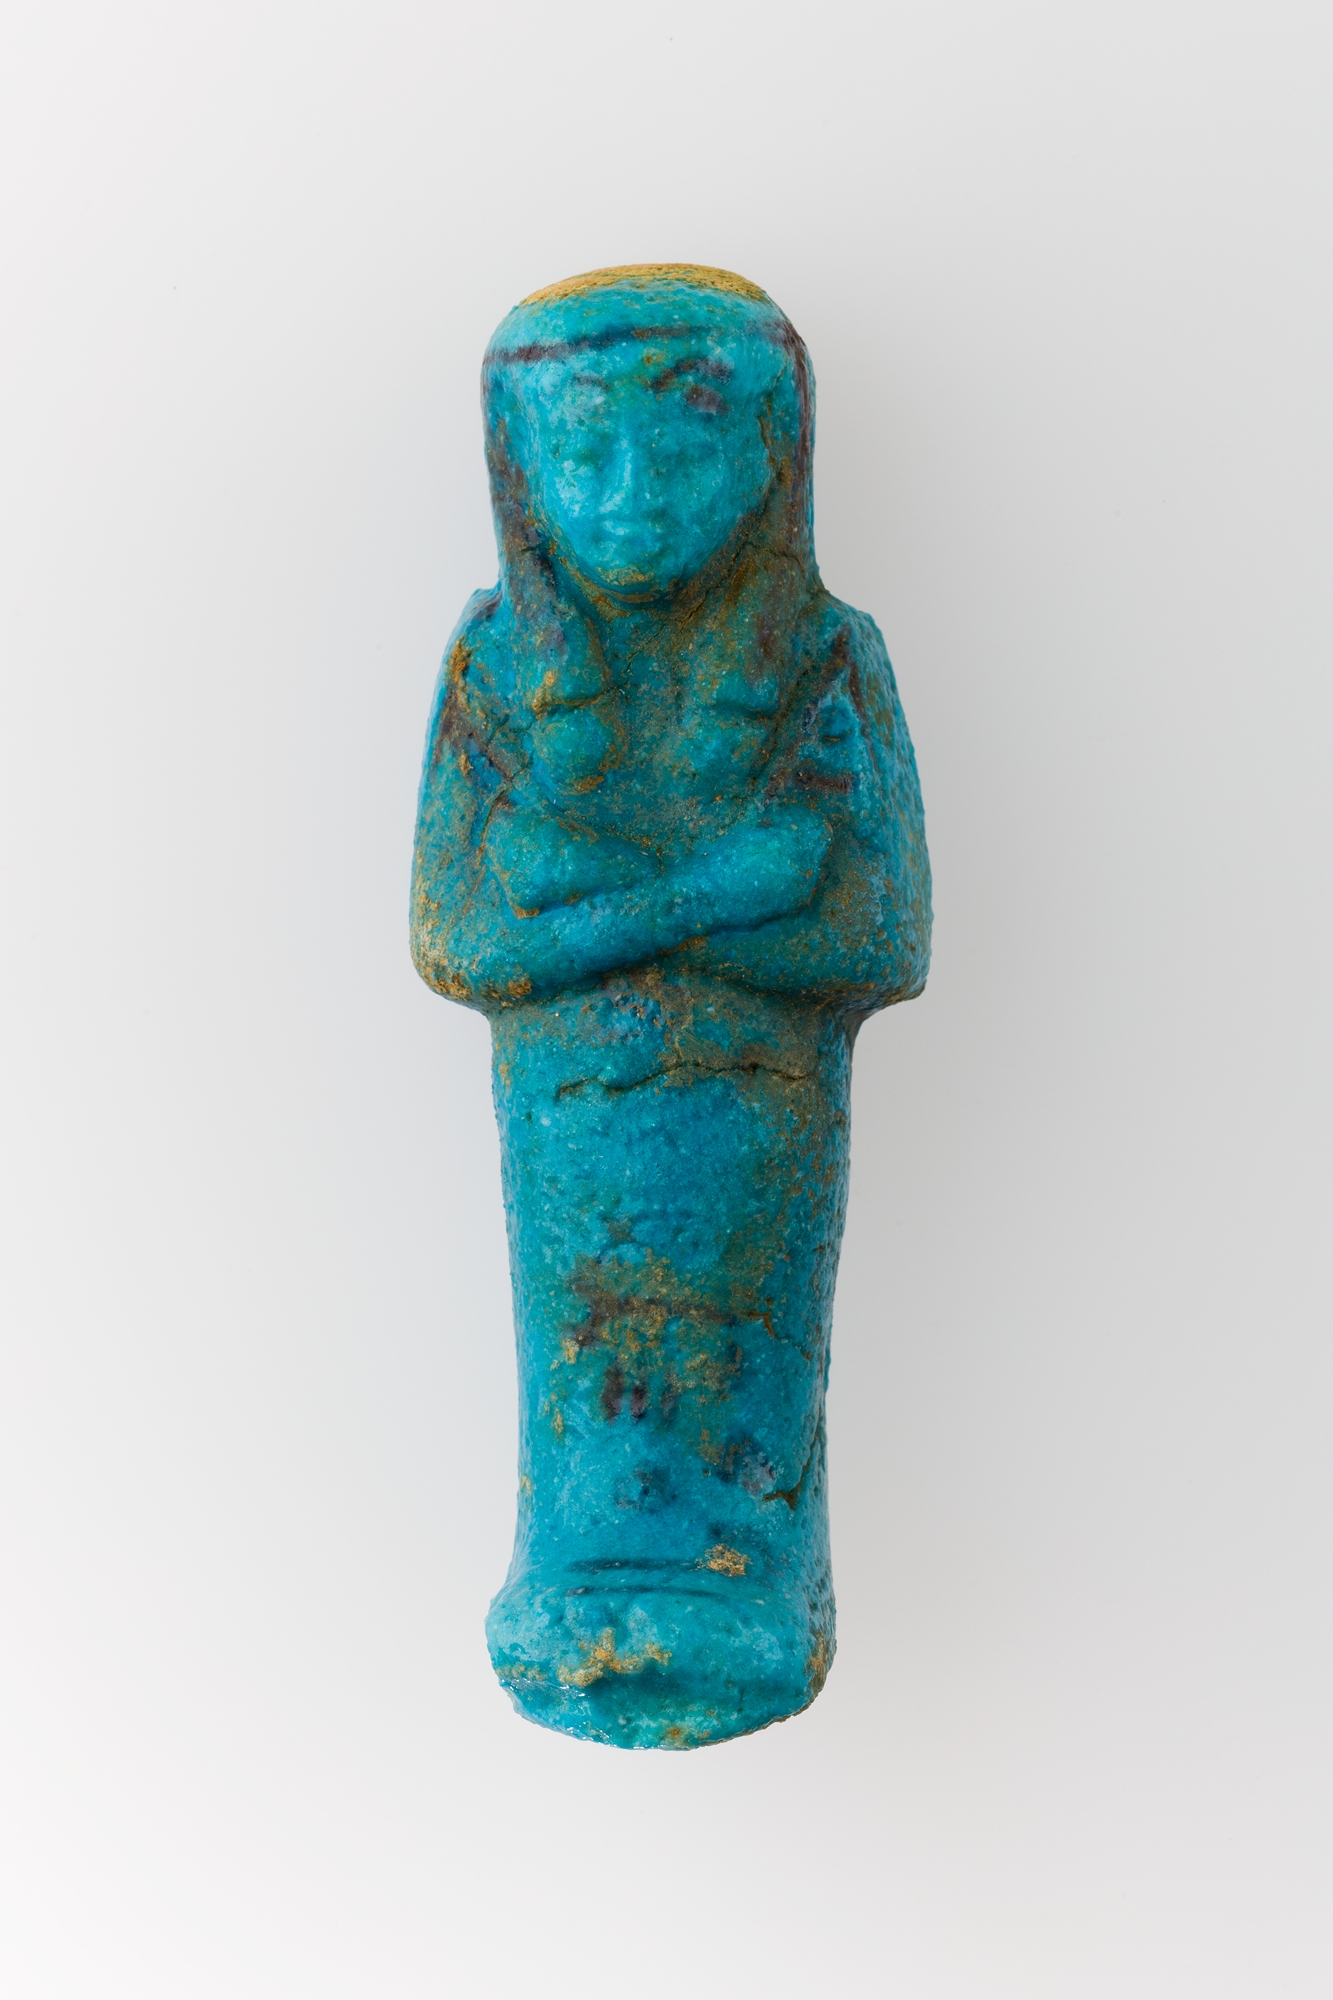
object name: shabti, henettawy c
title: Worker Shabti of Henettawy (C), Daughter of Isetemkheb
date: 990-970 BCE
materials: faience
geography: egypt